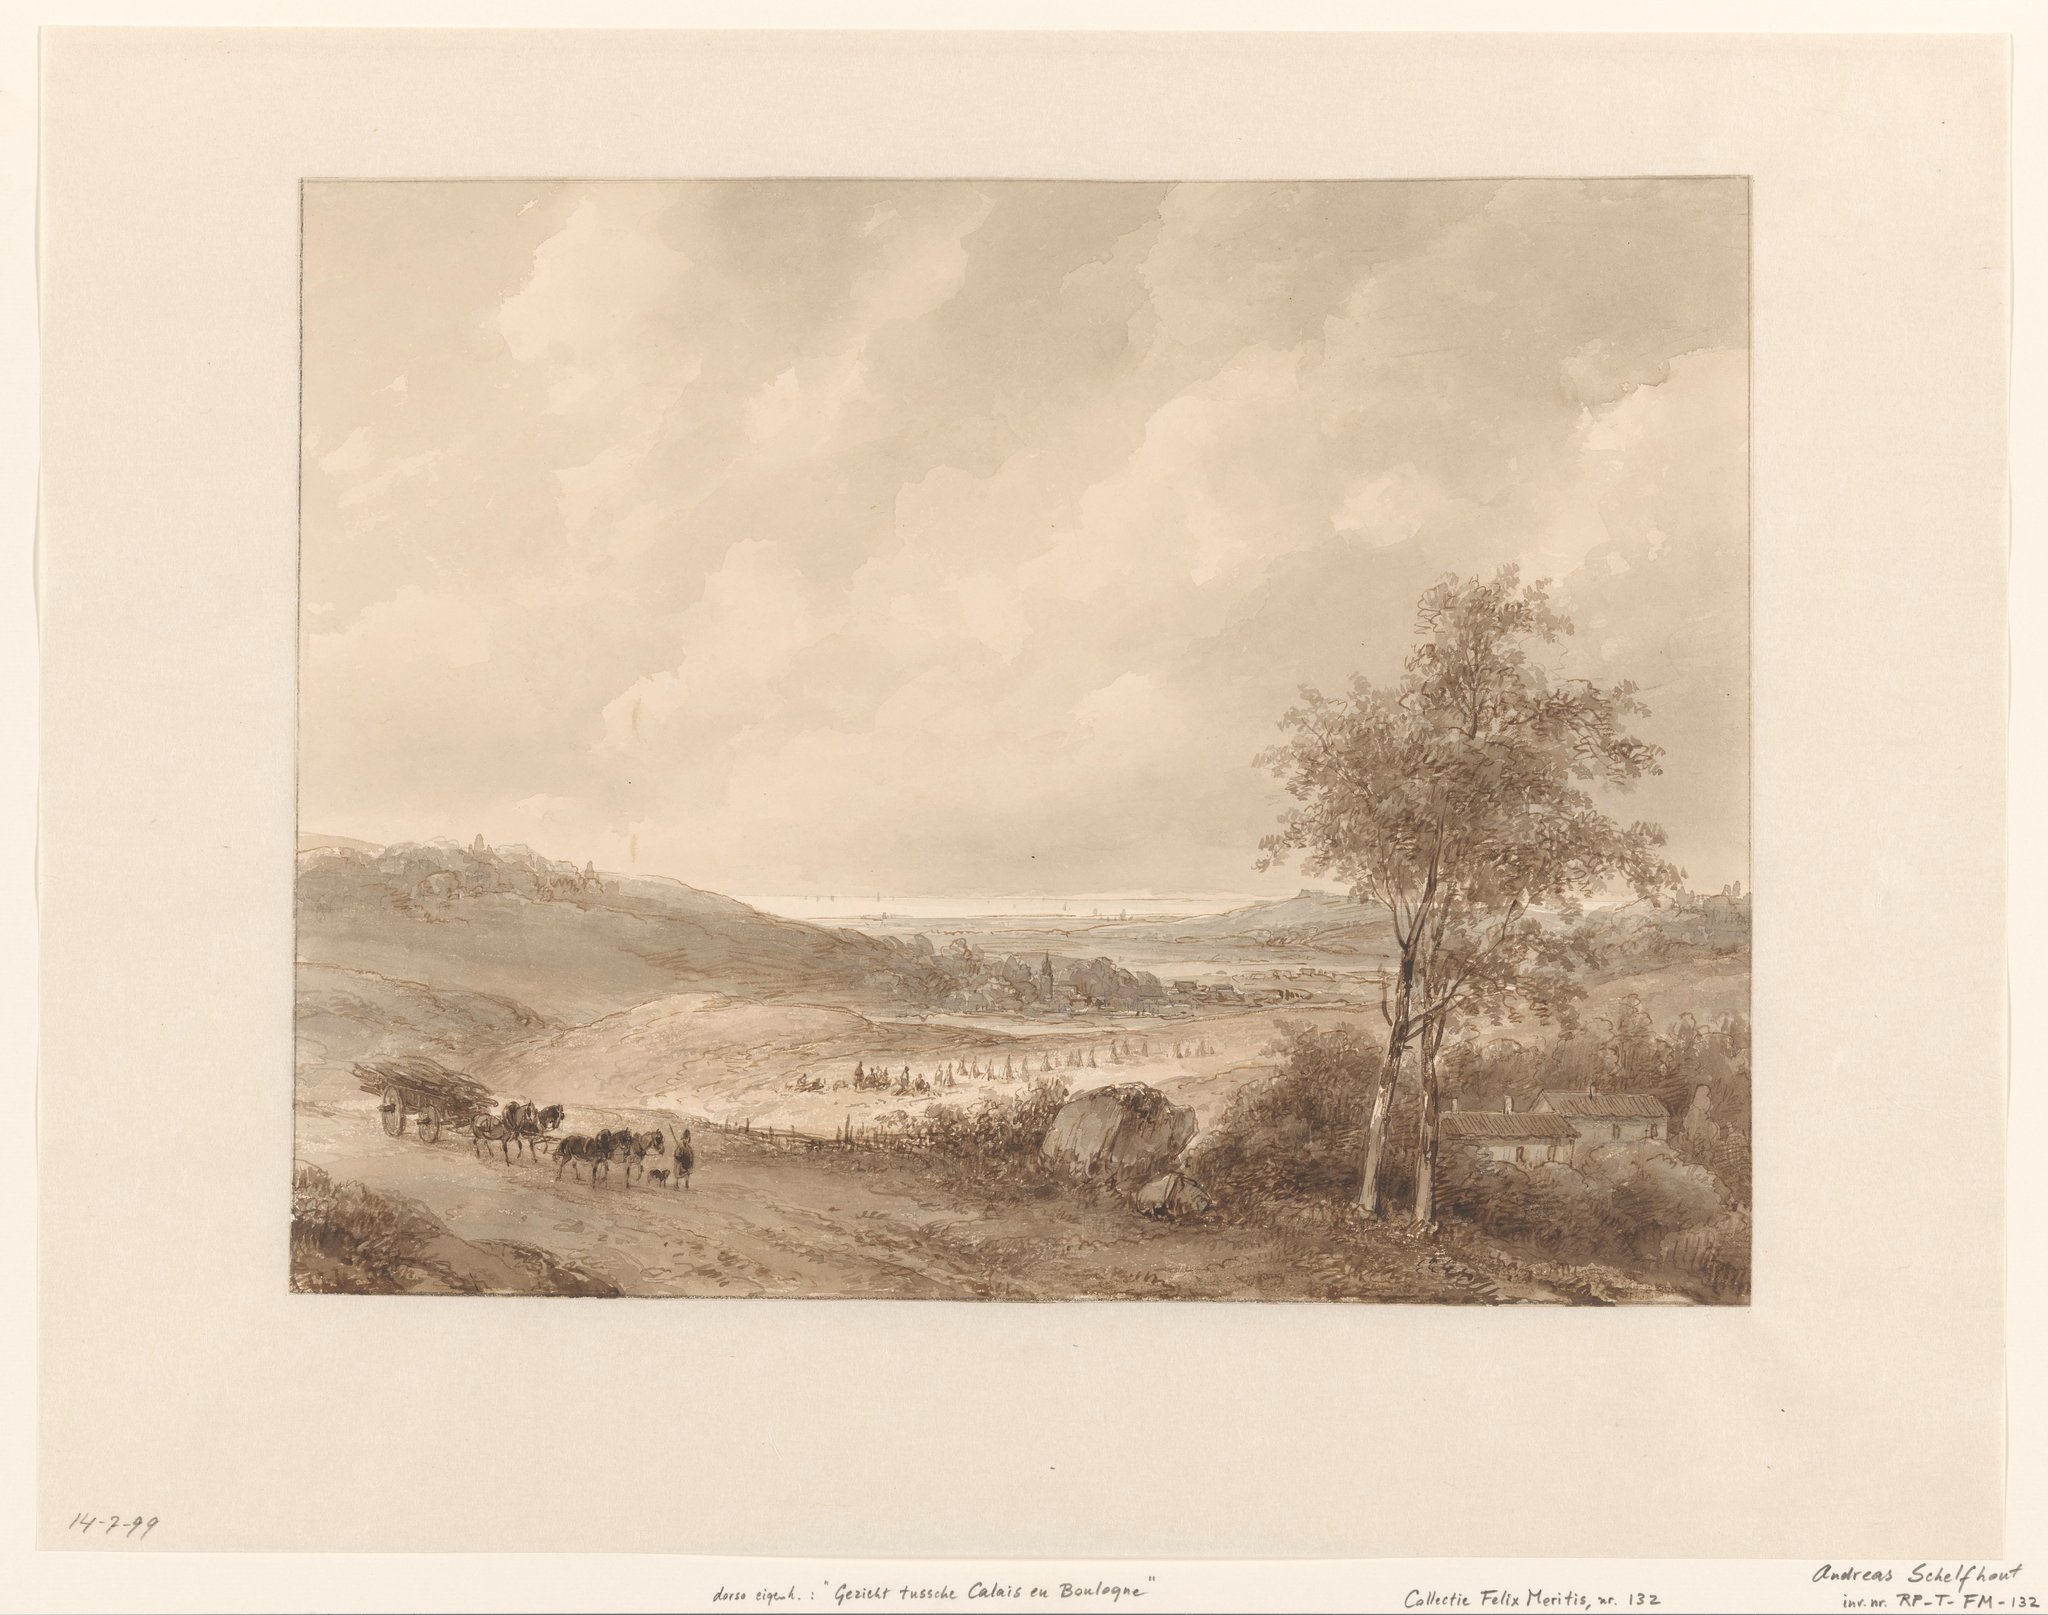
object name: drawing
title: Landschap tussen Calais en Boulogne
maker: andreas schelfhout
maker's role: draughtsman, painter, print maker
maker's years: 1787-1870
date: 1797-1870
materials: ink, paper, pencil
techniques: brush, pen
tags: coast, france